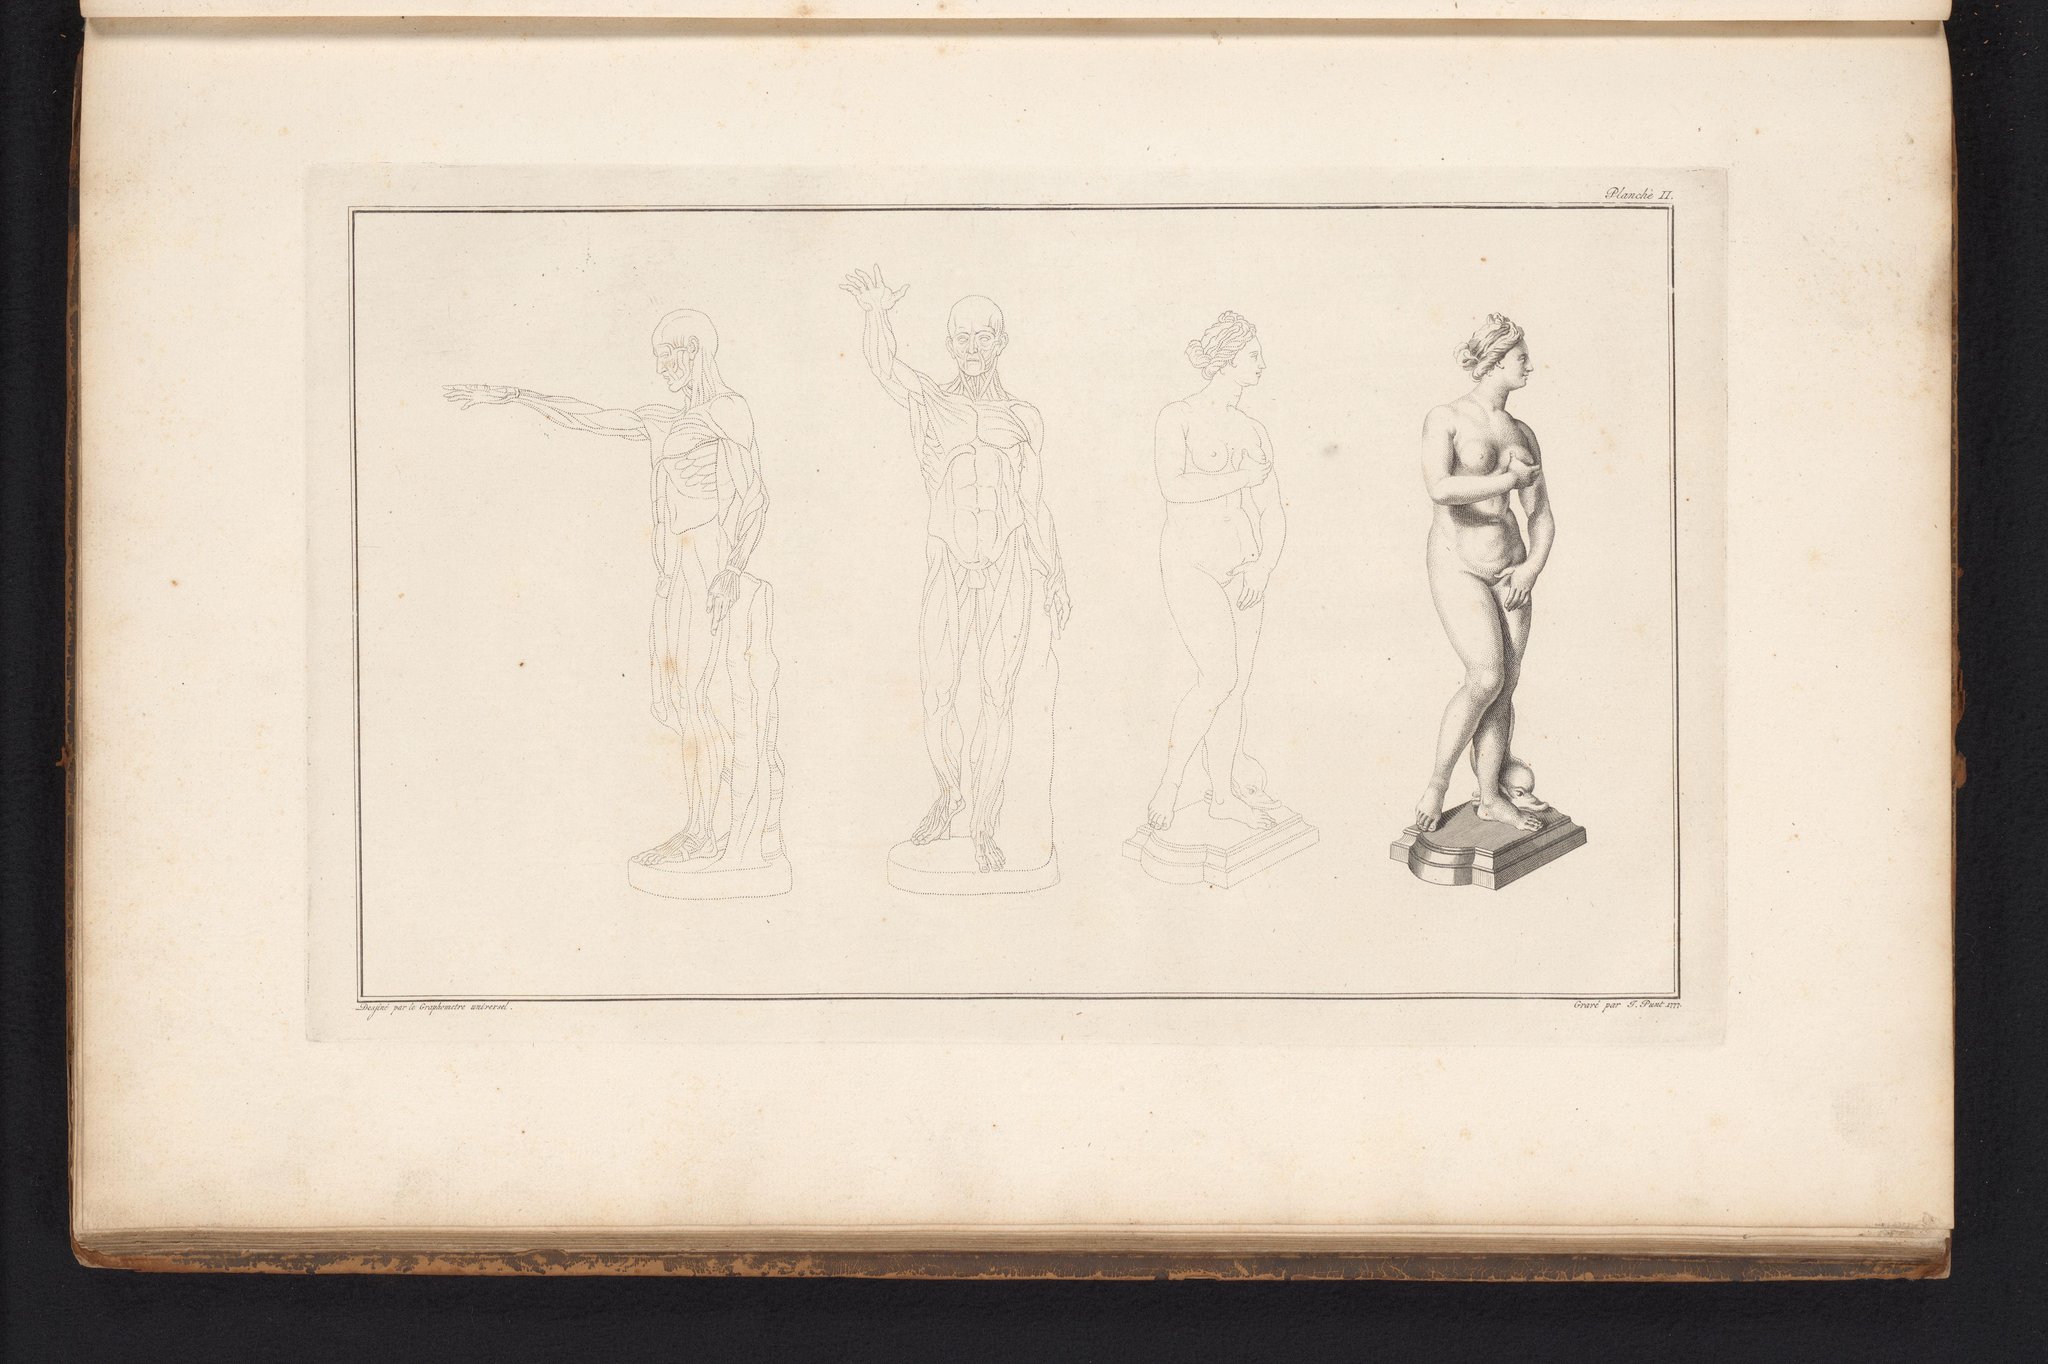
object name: album leaf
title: Anatomisch beeld en een Griekse Venus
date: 1777-1778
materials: paper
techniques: engraving, etching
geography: amsterdam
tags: anatomy (non-medical), sculpture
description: Een anatomisch beeld en een Griekse Venus, deels alleen in omtrek getekend met behulp van een grafometer. Rechtsboven gemerkt: Planche II. De prent maakt deel uit van het boek: A.G. Eckhardt, Beschryving van een algemeenen graphometer, 1778.